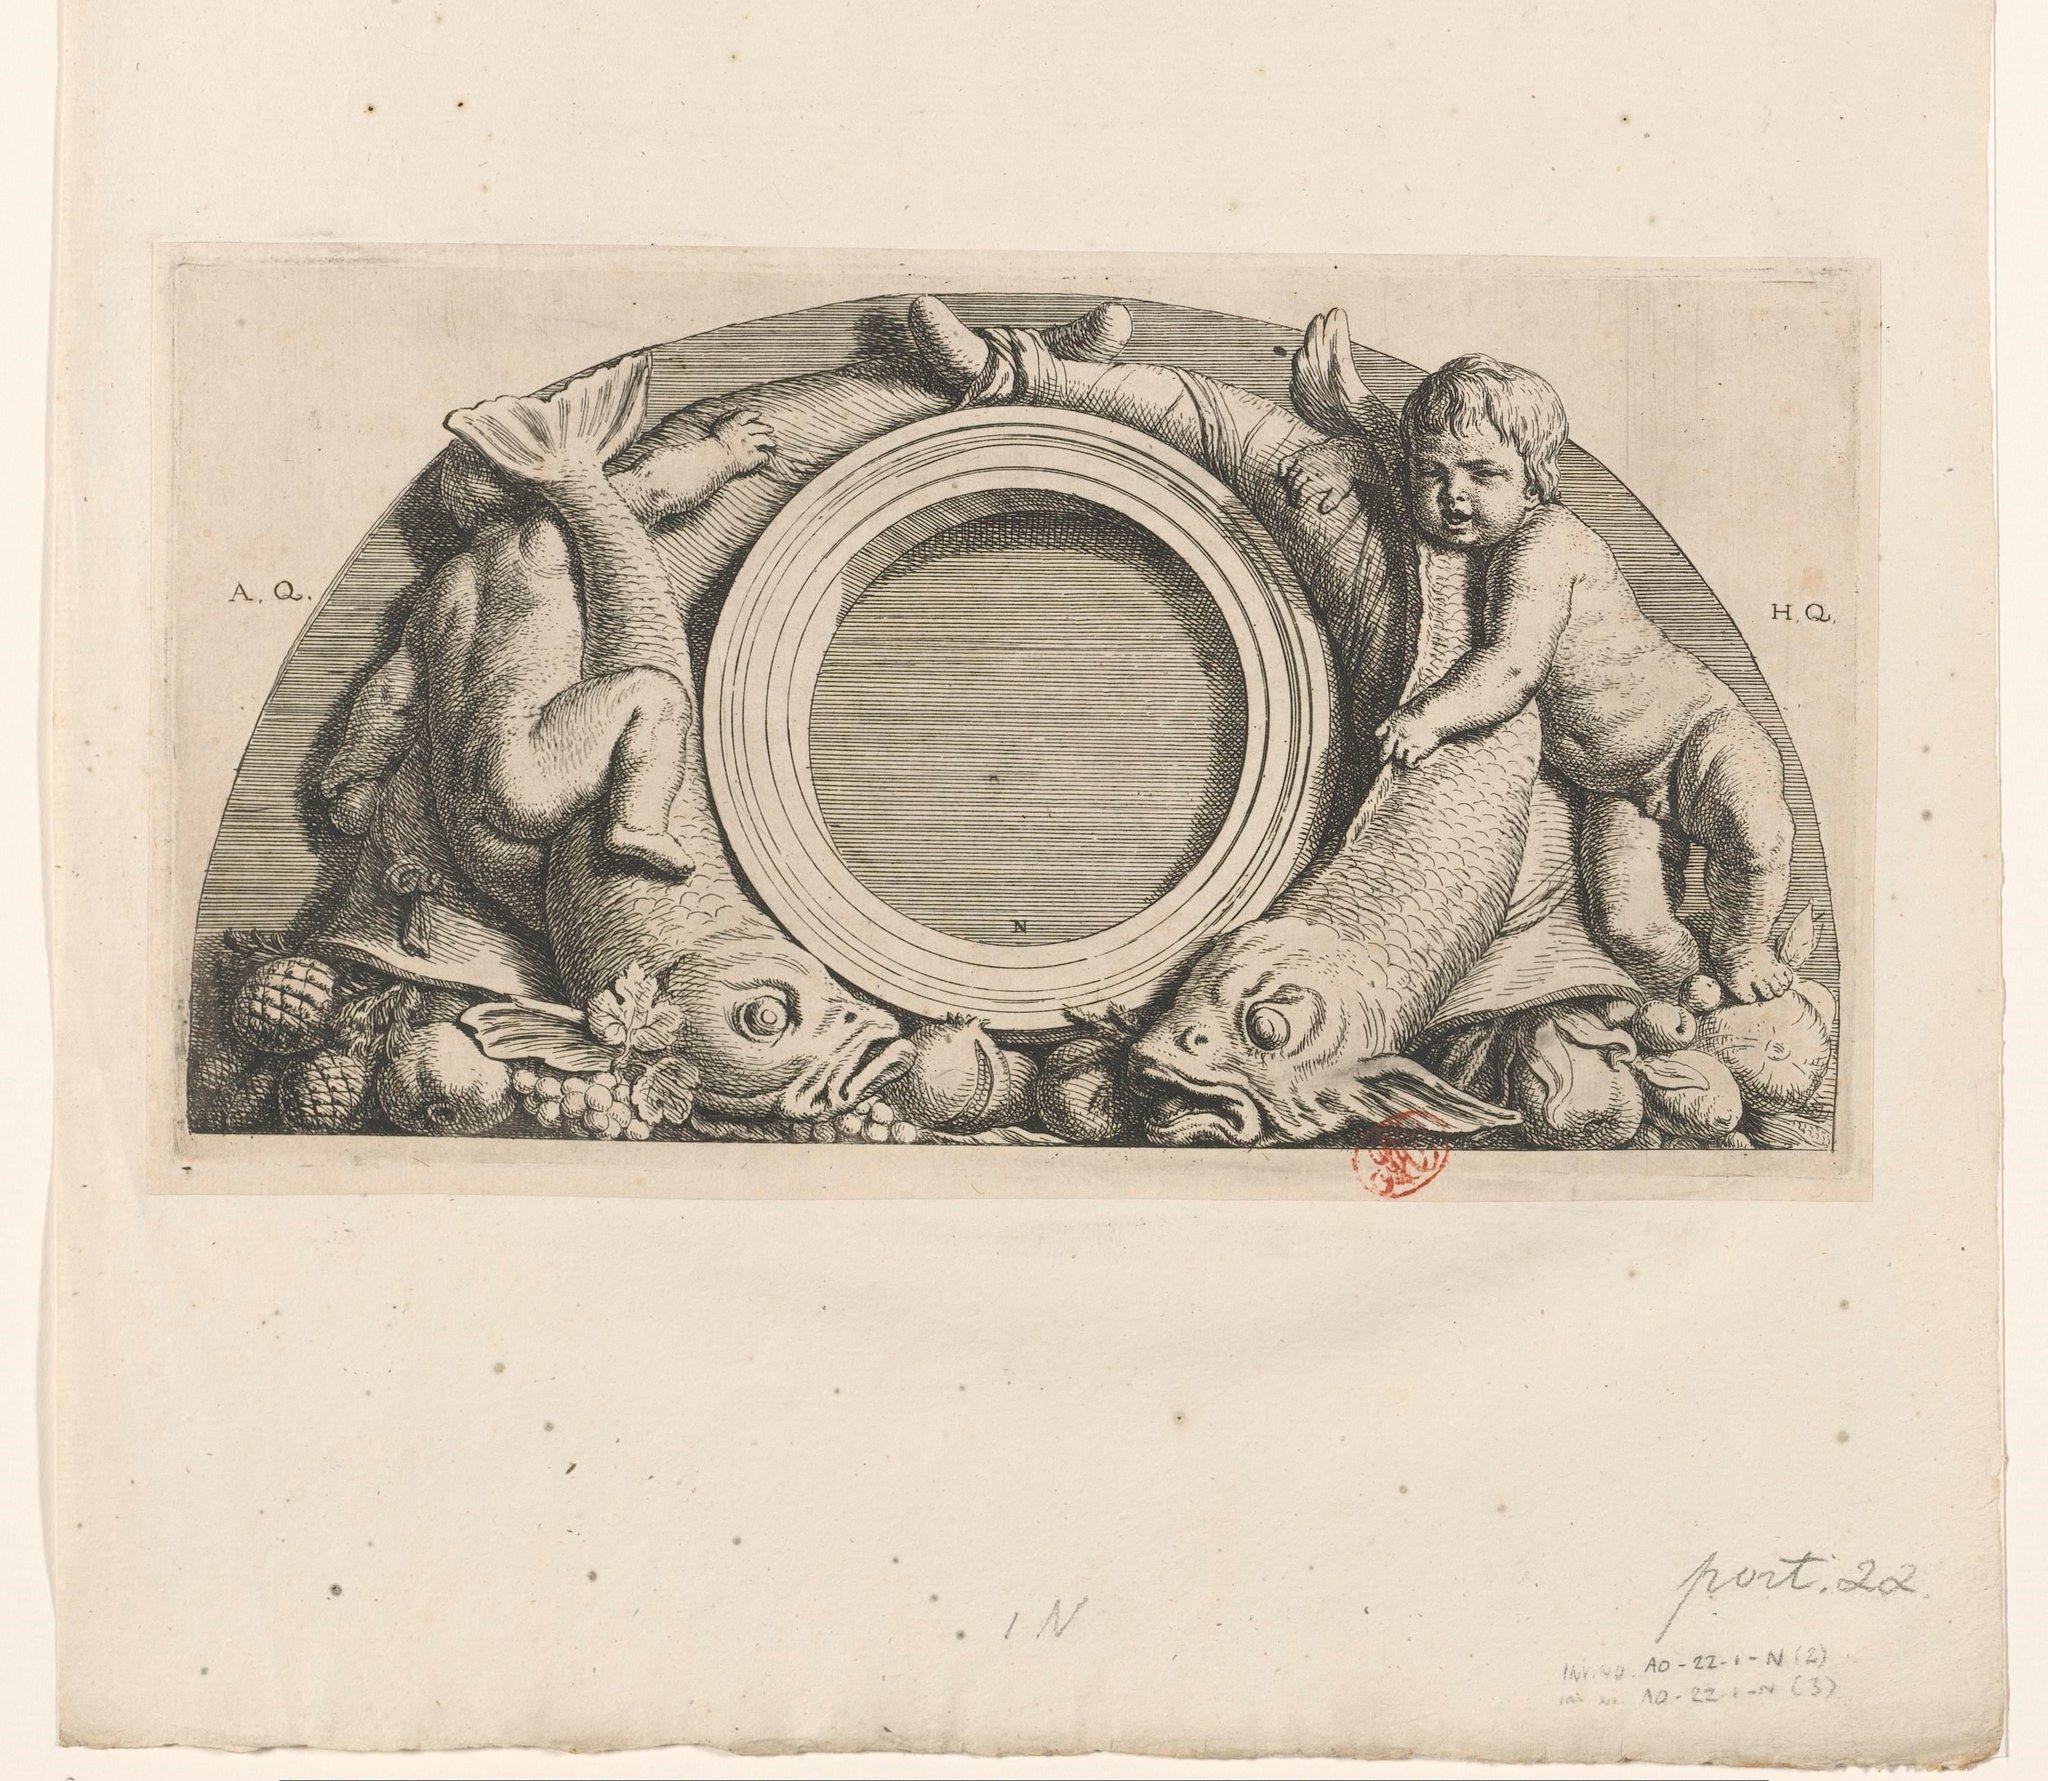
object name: print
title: Lunette met putti, vissen en hoornen des overvloeds in de oostelijke galerij van het Stadhuis op de Dam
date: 1655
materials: paper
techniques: engraving, etching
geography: amsterdam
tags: 'cornucopia', horn of plenty, fishes, cupids: 'amores', 'amoretti', 'putti'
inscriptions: collector's mark: Lugt 195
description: Prent gebruikt in: Prima pars. Praecipuarum effigierum ac ornamentorum, amplissimae Curiae Amstelrodamensis (…) / Het eerste deel. Van de voornaemste Statuen ende Ciraten, vant konstijck Stadhuys van Amstelredam, tmeeste in marmer gemaeckt, door Artus Quellinus, Beelthouwer der voorseyde Stadt / La Premier Partie. De plusieurs Figures et ornements, de la Maison de Ville d'Amsterdam (…). Amsterdam: Artus Quellinus (I), 1655. Zie RP-P-AO-22-1-1 voor bijhorende titelpagina. Zie RP-P-AO-22-1-2 voor bijhorend register. Zie RP-P-AO-22-1A, RP-P-AO-22-1B, RP-P-AO-22-1C, RP-P-AO-22-1D-1, RP-P-AO-22-1D-2, RP-P-AO-22-1E, RP-P-AO-22-1F, RP-P-AO-22-1G, RP-P-AO-22-1H, RP-P-AO-22-1I, RP-P-AO-22-1K-1, RP-P-AO-22-1K-2, RP-P-AO-22-1K-3, RP-P-AO-22-1K-4, RP-P-AO-22-1K-5, RP-P-AO-22-1L-1, RP-P-AO-22-1L-2, RP-P-AO-22-1M-1, RP-P-AO-22-1M-2, RP-P-AO-22-1N-1, RP-P-AO-22-1N-2, RP-P-AO-22-1N-4, RP-P-AO-22-1N-5, RP-P-AO-22-1O-1, RP-P-AO-22-1O-2, RP-P-AO-22-1O-3, RP-P-AO-22-1O-4, RP-P-AO-22-1P-1, RP-P-AO-22-1P-2, RP-P-AO-22-1P-3, RP-P-AO-22-1P-4, RP-P-AO-22-1Q-1, RP-P-AO-22-1Q-2, RP-P-AO-22-1Q-3, RP-P-AO-22-1Q-4, RP-P-AO-22-1R-1, RP-P-AO-22-1R-2, RP-P-AO-22-1R-3, RP-P-AO-22-1R-4, RP-P-AO-22-1R-5, RP-P-AO-22-1S-1, RP-P-AO-22-1S-2, RP-P-AO-22-1S-3, RP-P-AO-22-1S-4, RP-P-AO-22-1S-5, RP-P-AO-22-1T-1 en RP-P-AO-22-1T-2 voor andere prenten uit deze publicatie. Zelfde staat van prent ook gebruikt in: Prima pars. Praecipuarum effigierum ac ornamentorum, amplissimae Curiae Amstelrodamensis (…) / Het eerste deel. Van de voornaemste Statuen ende Ciraten, vant konstijck Stadhuys van Amstelredam, tmeeste in marmer gemaeckt, door Artus Quellinus, Beelthouwer der voorseyde Stadt / La Premier Partie. De plusieurs Figures et ornements, de la Maison de Ville d'Amsterdam (…). Amsterdam: Frederik de Wit, 1665. Latere staat van prent ook gebruikt in: Architecture peinture et sculpture de la Maison de Ville d'Amsterdam, representee en CIX. figures en taille-douce (…). Amsterdam: David Mortier, 1719. En in: Architecture peinture et sculpture de la Maison de Ville d'Amsterdam, representee en CIX. figures en taille-douce (…). Amsterdam: Gerard Valck, 1719. En in: Bouw schilder en beeldhouwkonst, van het Stadhuis te Amsteldam, vertoont in CIX figuuren (…). Amsterdam: Covens & Mortier & Covens Jr., s.a. (1774-1783).